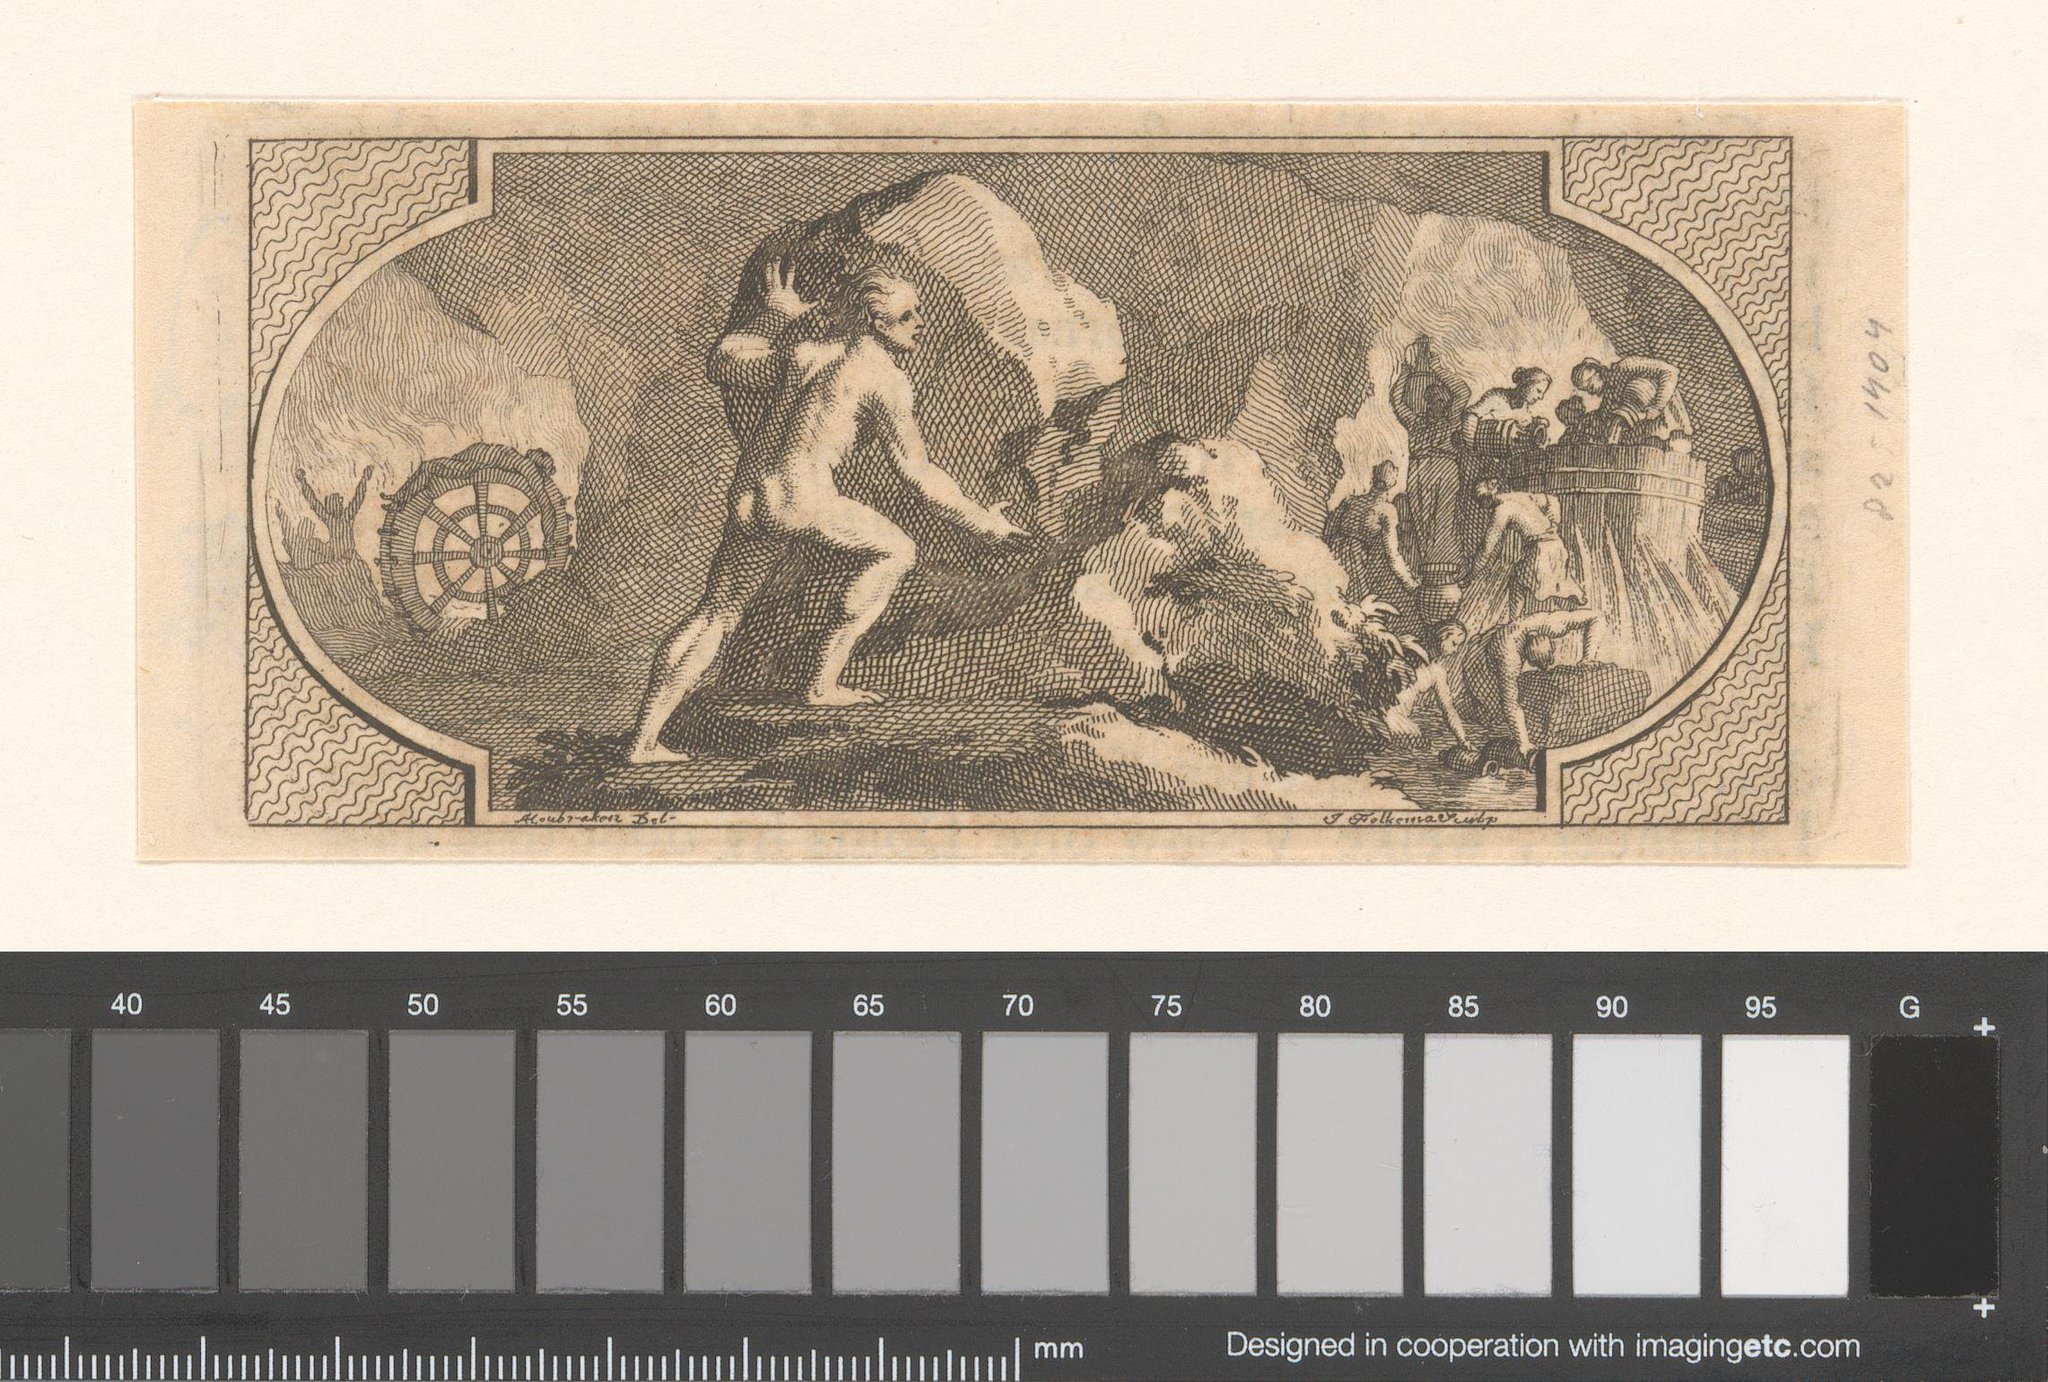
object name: print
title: Straf van Sisyphus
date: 1729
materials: paper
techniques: etching, letterpress printing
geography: the hague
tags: vignette, sisyphus pushing his boulder uphill or carrying it on his shoulders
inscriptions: collector's mark: Lugt 2760, collector's mark: Lugt 2228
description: Prent uit: Weyerman, Jacob Campo. De levens-beschryvingen der Nederlandsche konst-schilders en konst-schilderessen (...). Den Haag: Wed. E. Boucquet et al., 1729, dl. 3, p. 24. Deze prent is in verschillende drukken van dit werk uit 1729 op verschillende plekken in het boek gebruikt.